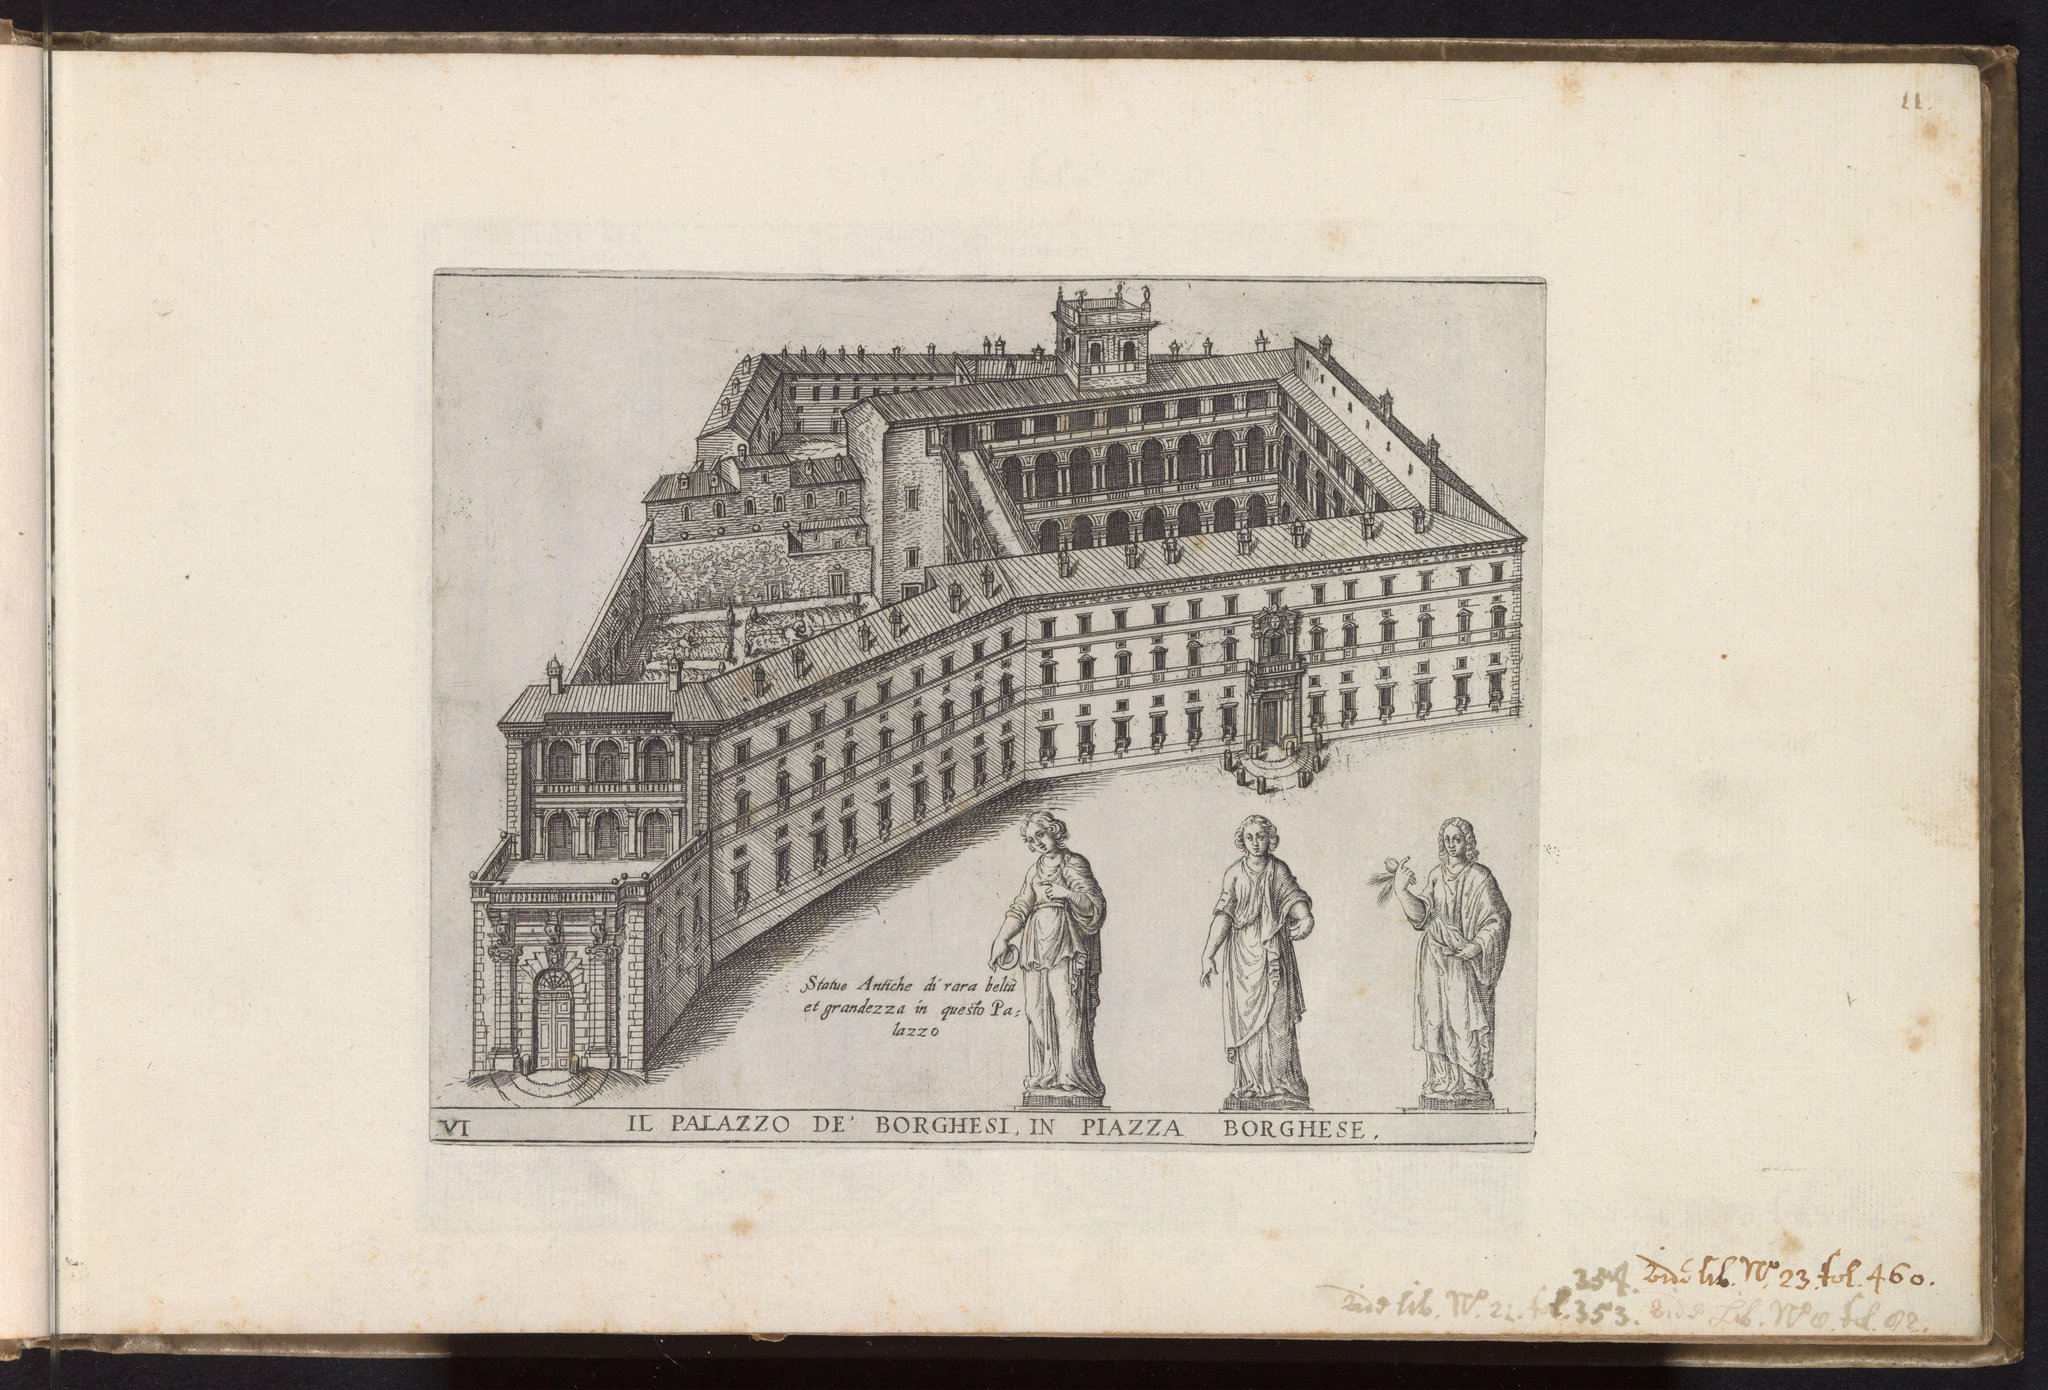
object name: album leaf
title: Il Palazzo de' Borghesi, in Piazza Borghese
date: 1618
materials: paper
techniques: engraving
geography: vatican city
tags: piece of sculpture, reproduction of a piece of sculpture, hôtel, i.e. small palace in city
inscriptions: number: ‘11’, inscription: ‘Ende lib. No. 23. fol. 460./ Ende lib. No. 21. fol. 353 [354]. Ende lib. No. 8. fol. 82.’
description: Gezicht op Palazzo Borghese te Rome. Rechtsonder drie standbeelden van vrouwelijke figuren. Titel in het Italiaans in ondermarge. Prent maakt deel uit van een album.